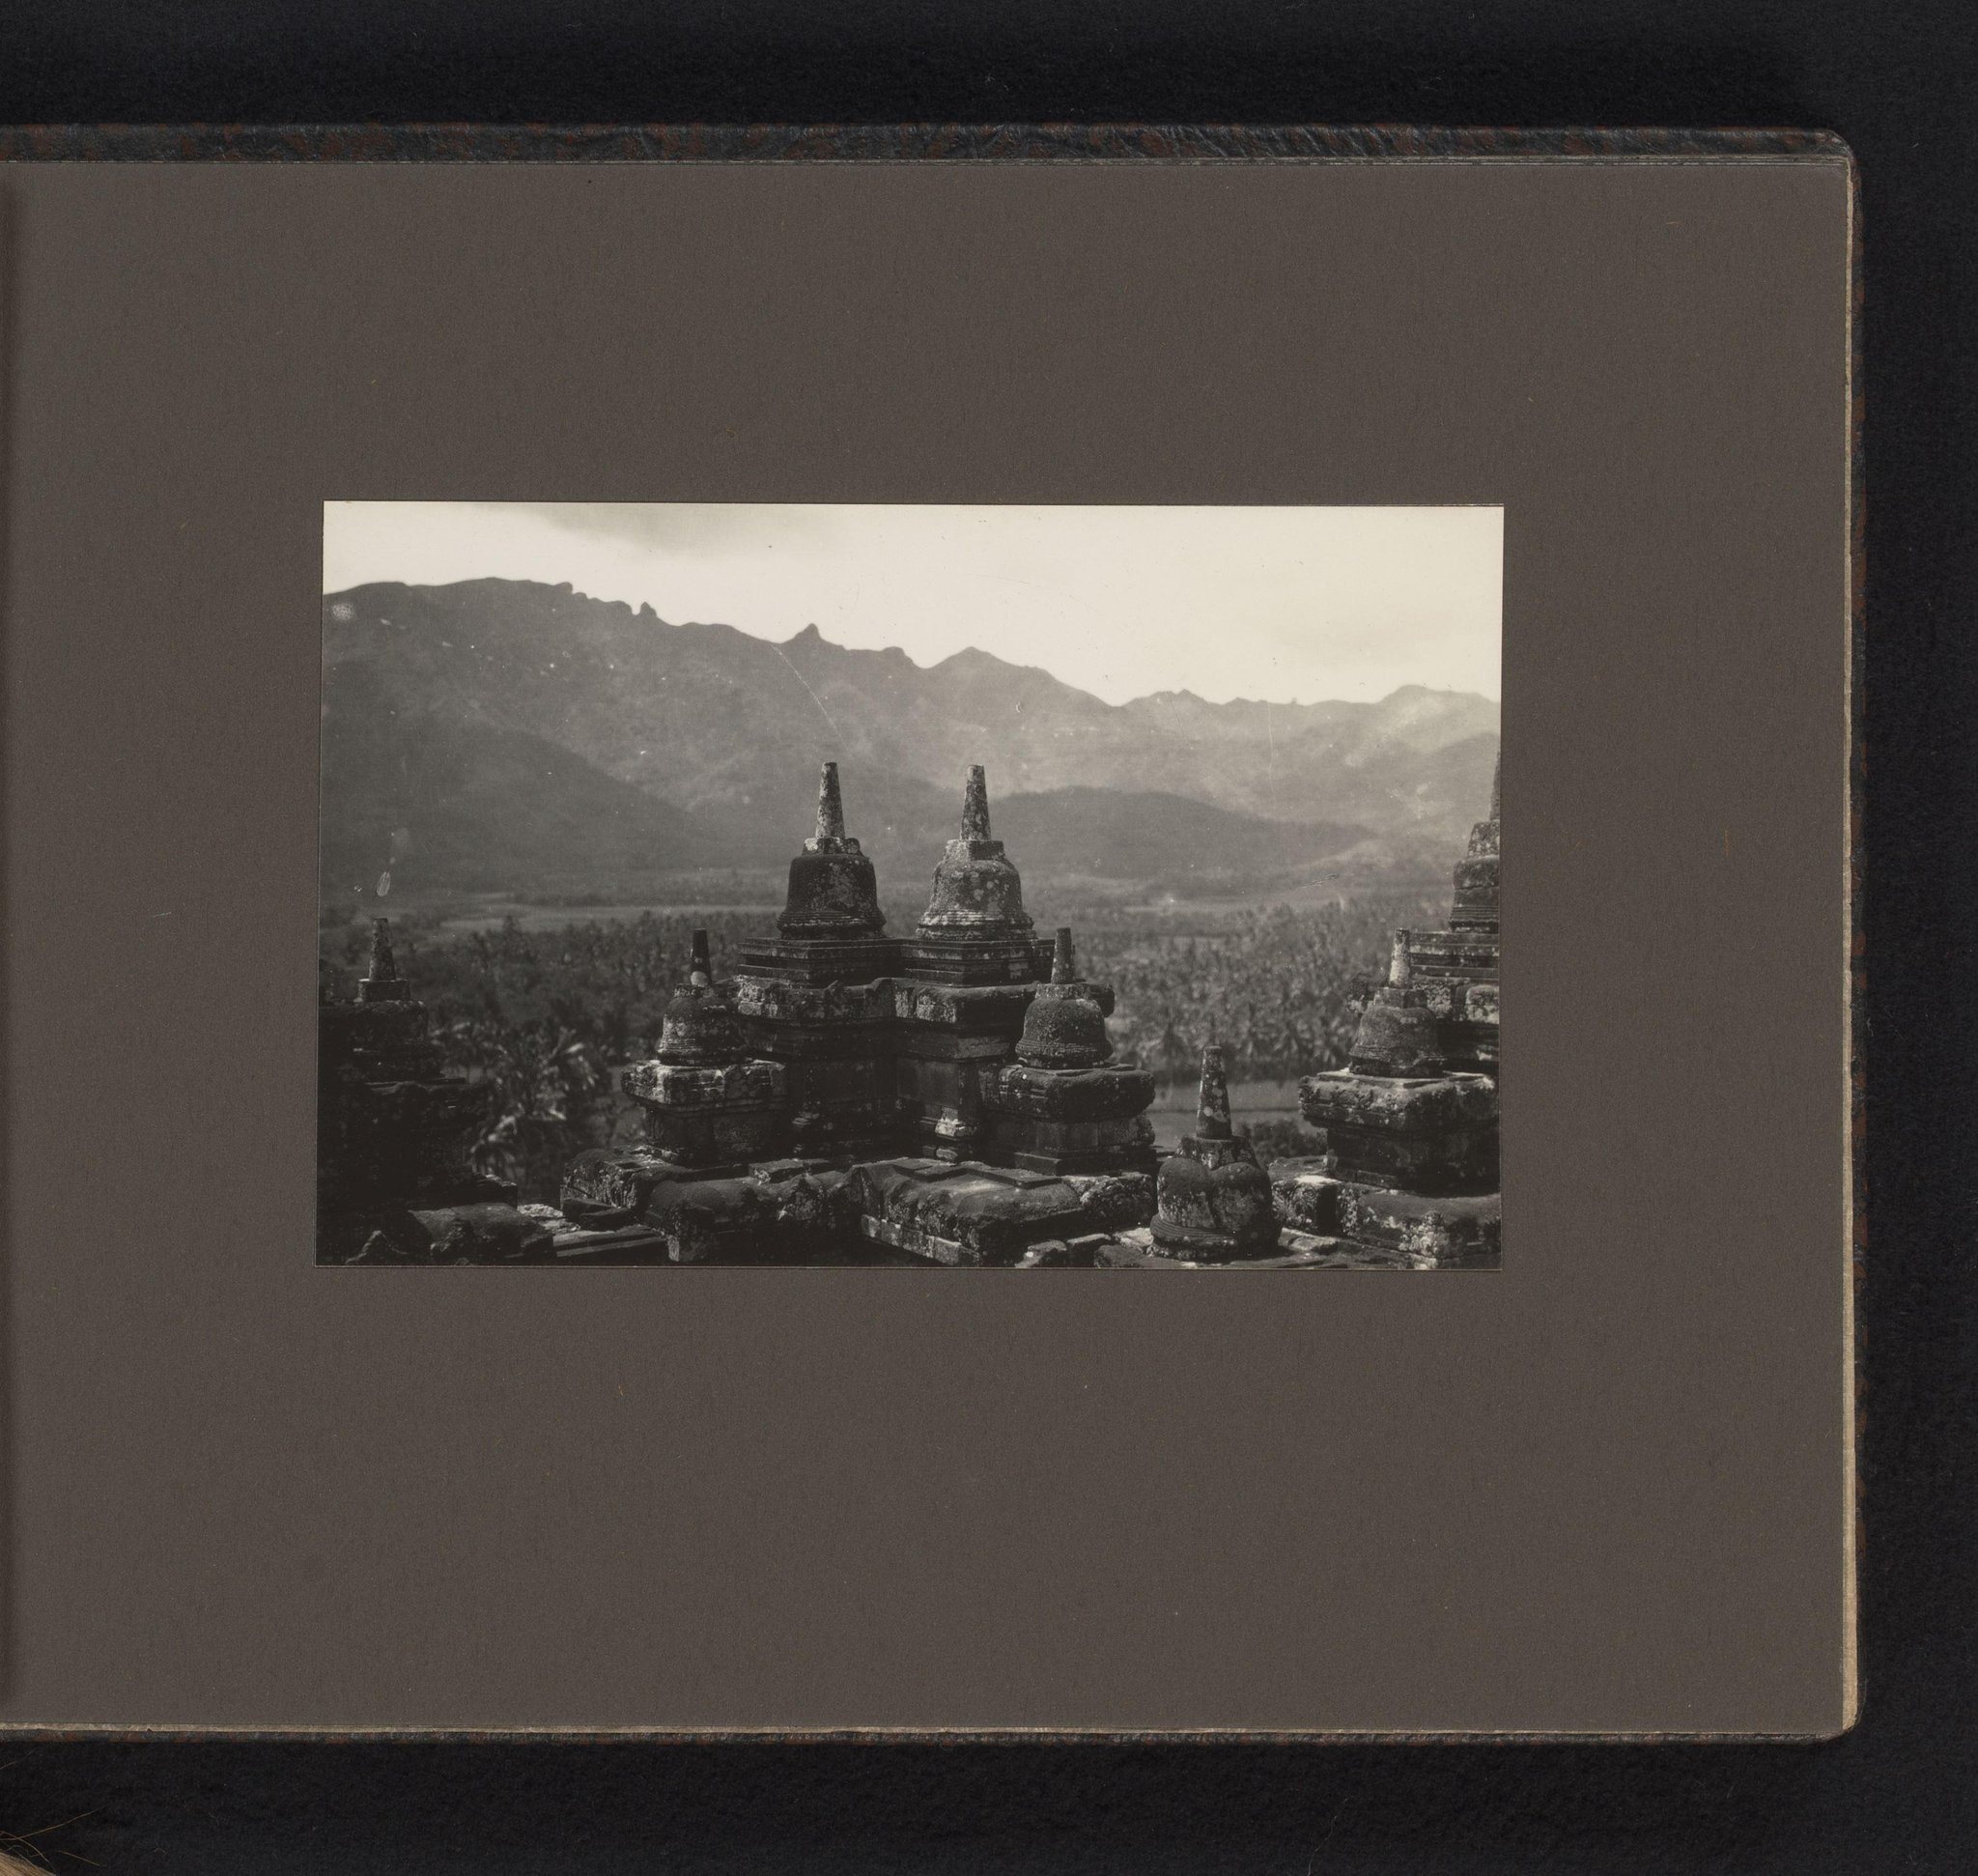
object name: photograph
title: Gezicht op de Borobudur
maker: adeline andrea. du celliée muller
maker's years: 1899-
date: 1930-1940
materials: paper, photographic support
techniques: gelatin silver print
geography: dutch east indies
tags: places and objects of worship ~ hinduism, buddhism, jainism, mountains